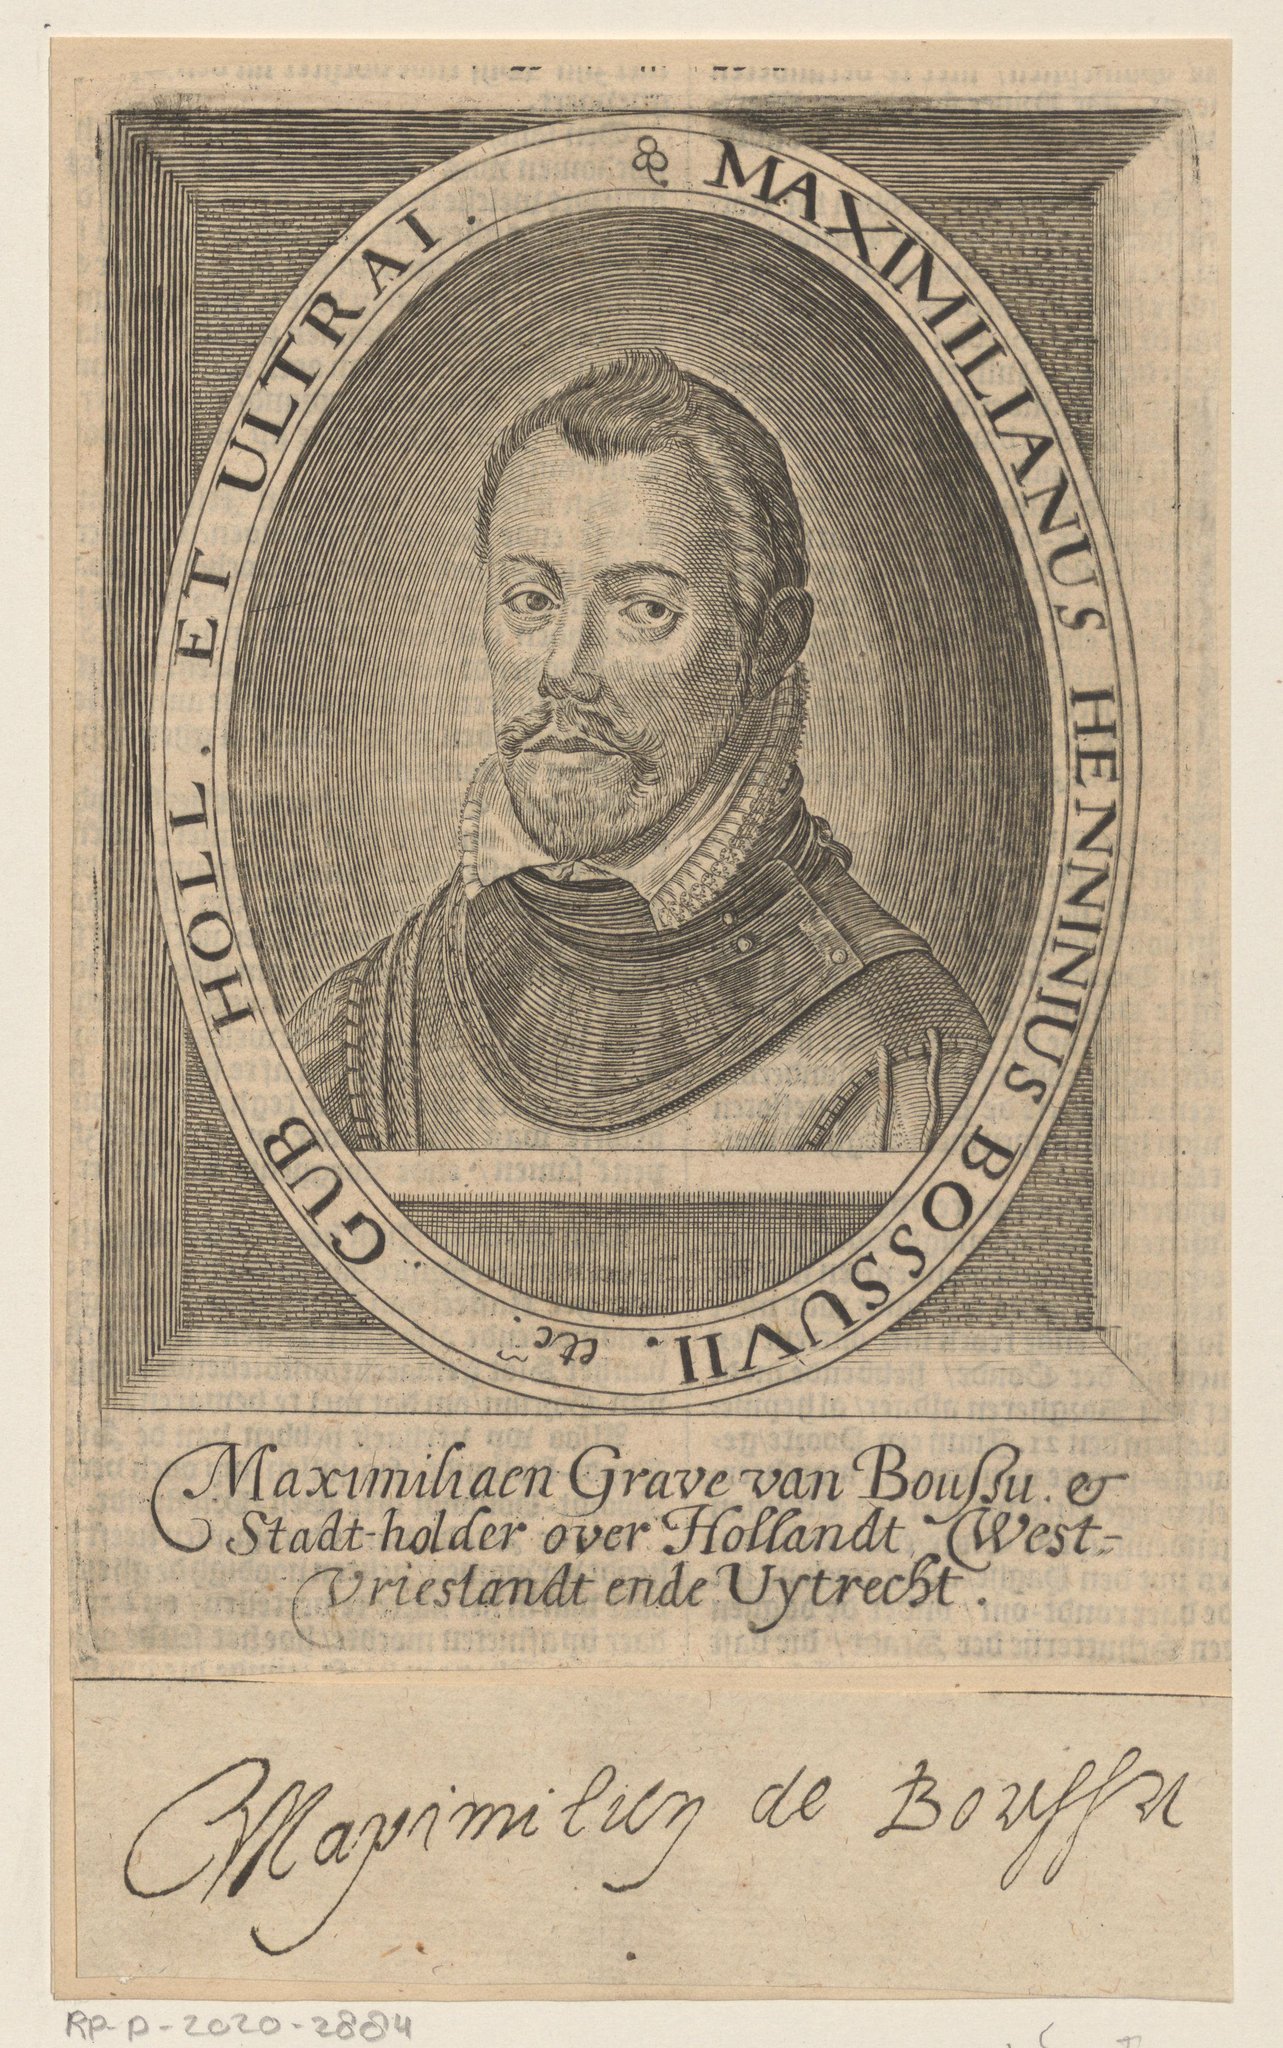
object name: print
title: Portret van Maximiliaan, graaf van Hennin-Lietard en Boussu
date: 1652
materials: paper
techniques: engraving, etching, letterpress printing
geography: amsterdam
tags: antwerp, earl, historical persons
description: Prent uit: Meteren, Emanuel van. Historien der Nederlanden, en haar naburen oorlogen tot het jaar 1612. Amsterdam: Jan Jacobsz. Schipper, 1652. Prent ook gebruikt in andere edities van dit werk. Onderaan is een geëtst signatuur geplakt met 'Maximilien de Boussu'.